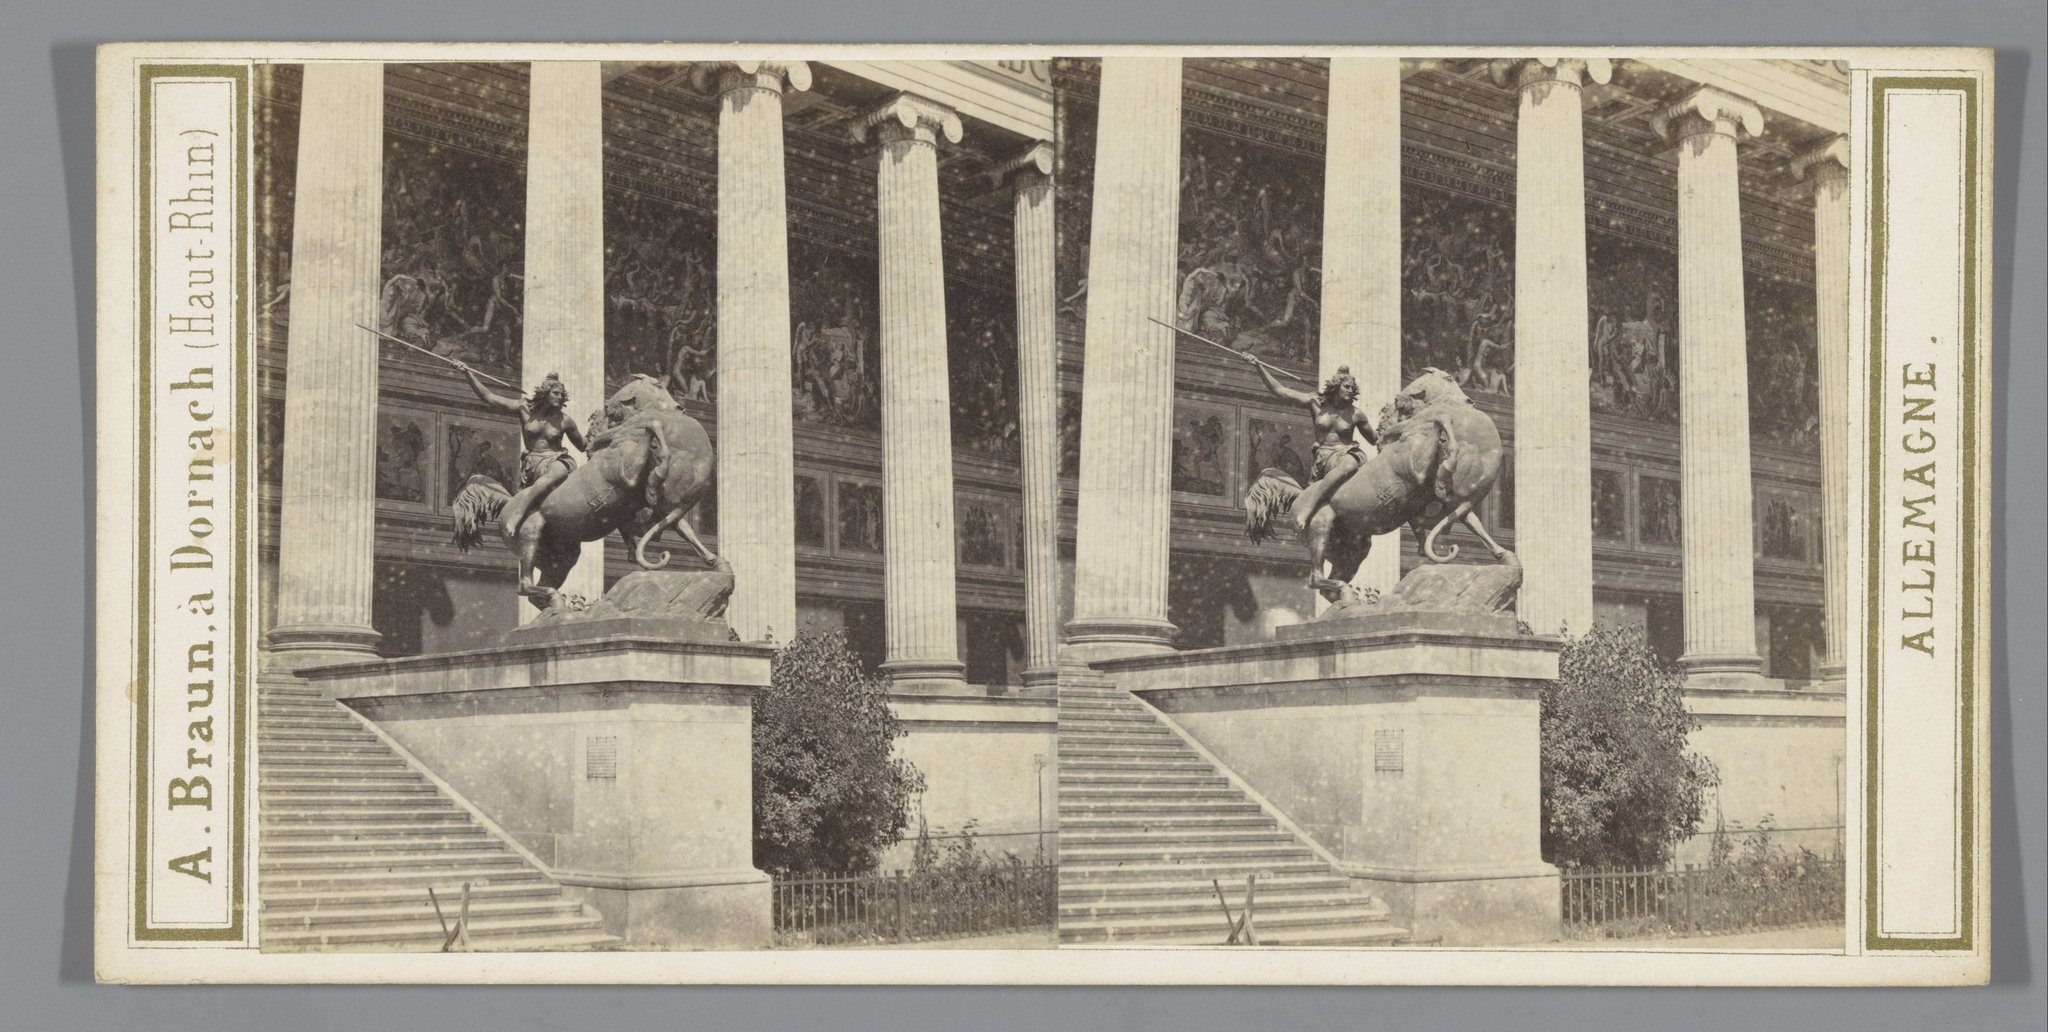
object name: stereograph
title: Amazone zu Pferde bij de entree van het Altes Museum in Berlijn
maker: Anonymous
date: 1860-1866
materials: cardboard, paper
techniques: albumen print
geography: dornach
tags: monument, statue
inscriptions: number: ‘No 3138.’